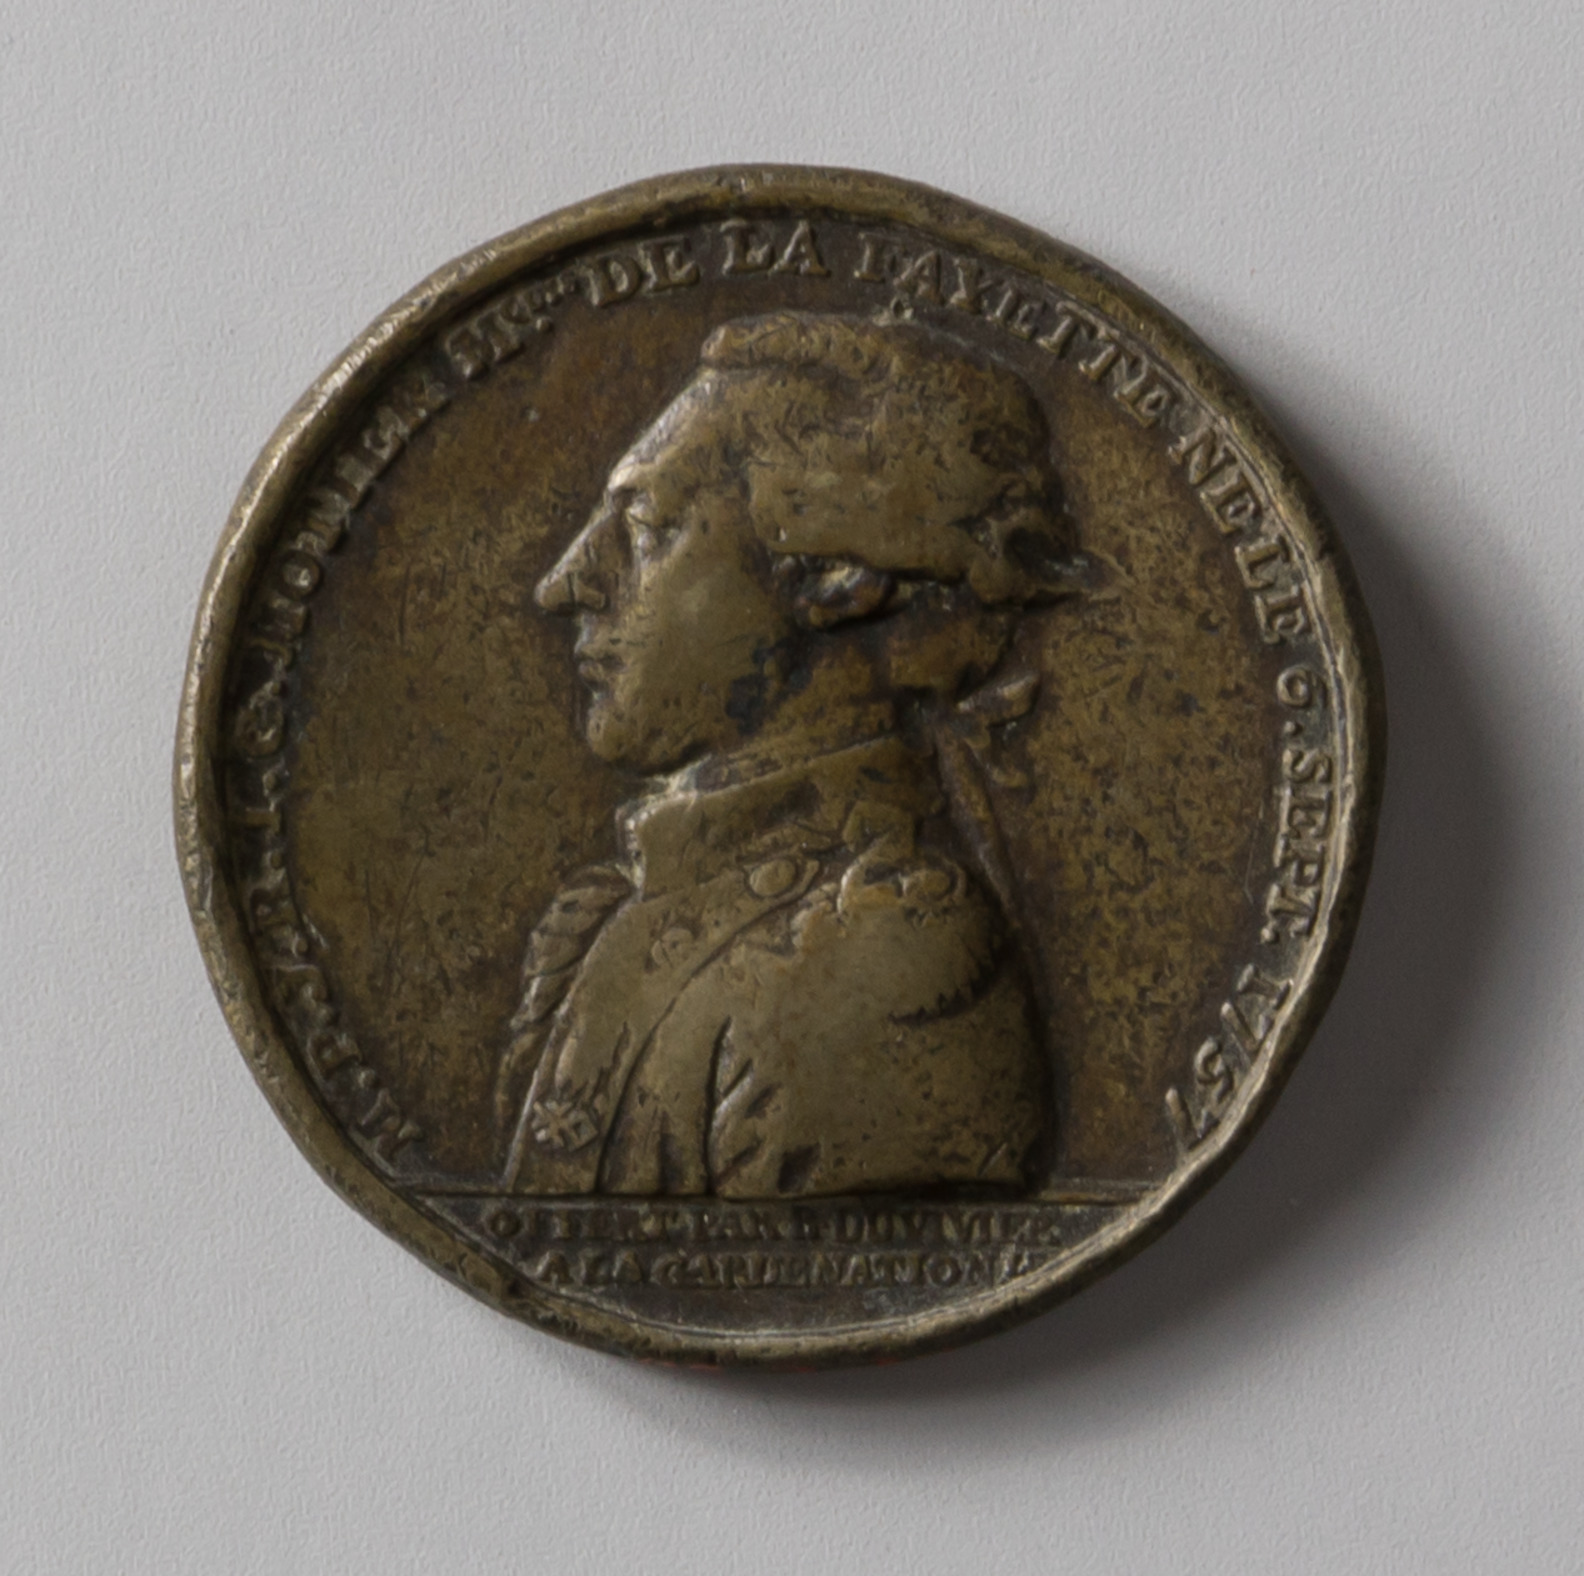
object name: medal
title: Medal of the Marquis de Lafayette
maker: pierre simon benj. duvivier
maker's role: maker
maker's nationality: french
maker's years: 1730-1819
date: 1789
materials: brass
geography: france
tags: men,profiles,marquis de lafayette